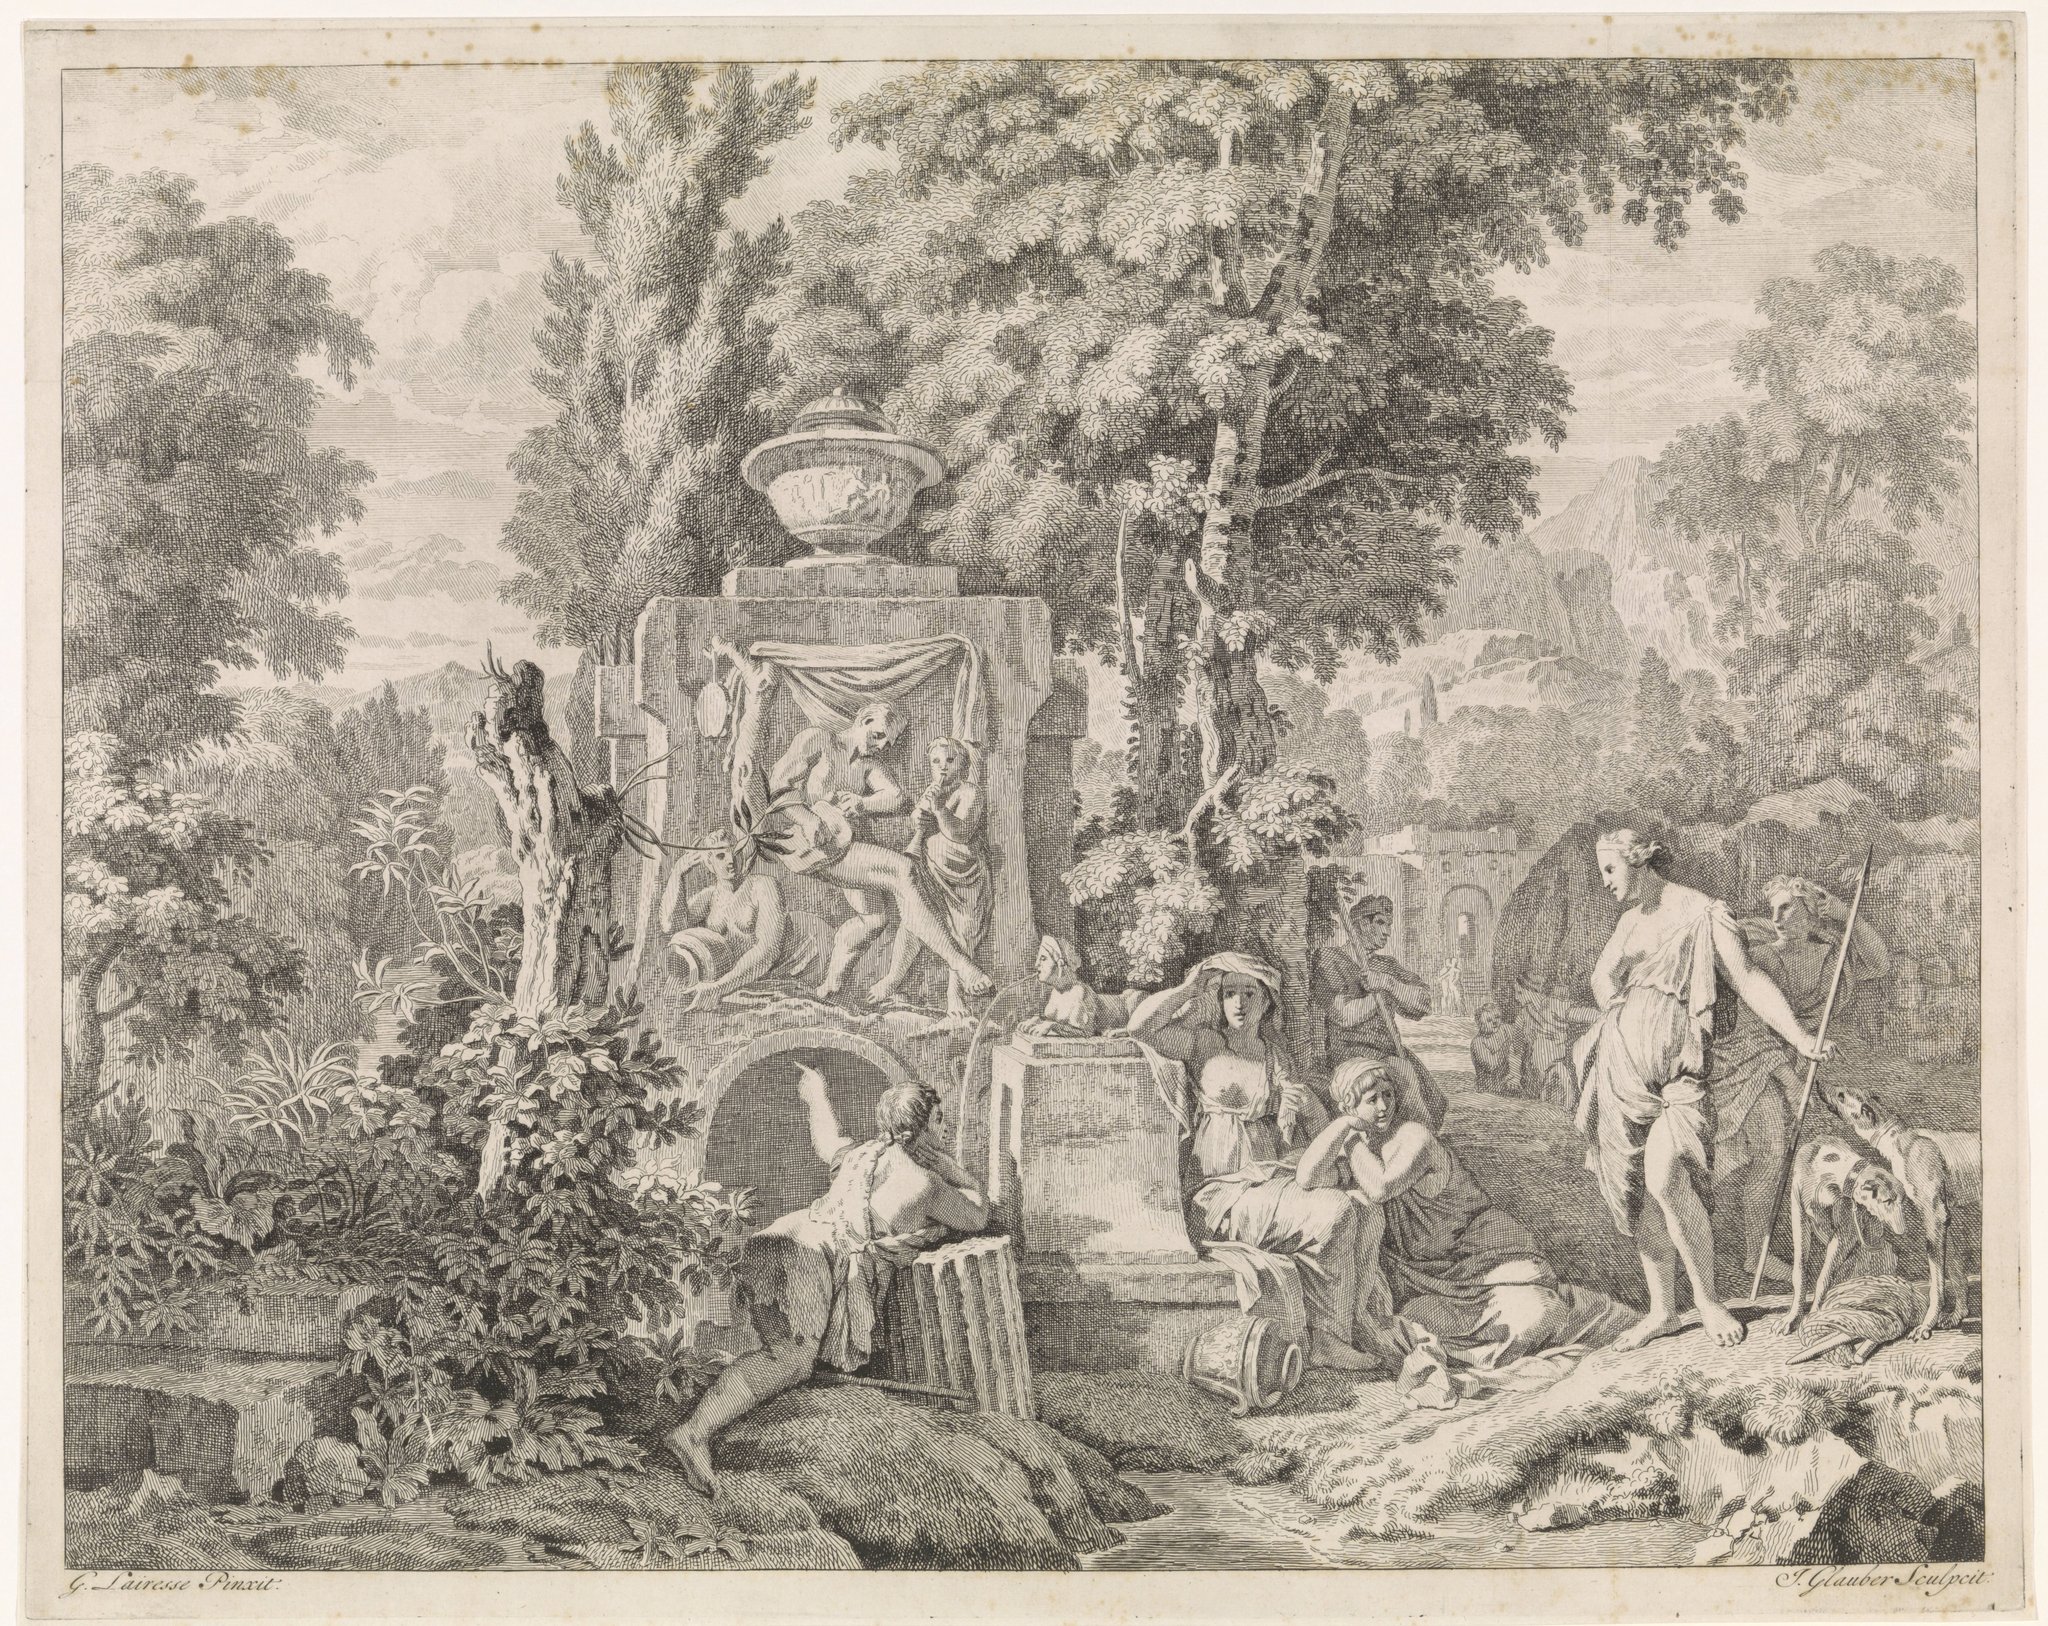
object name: print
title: Landschap met een fontein en Diana en haar nimfen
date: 1685-1689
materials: paper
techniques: etching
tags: companions, nymphs of diana; 'ninfe di diana' (ripa), (story of) diana (artemis), garden fountain, pastorals, arcadian scenes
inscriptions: collector's mark: Lugt 240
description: Een arcadisch landschap met centraal een klassiek-Romeinse fontein. Diana en haar nimfen rondom de fontein. De prent maakt deel uit van een serie met Bijbelse, mythologische en allegorische voorstellingen.